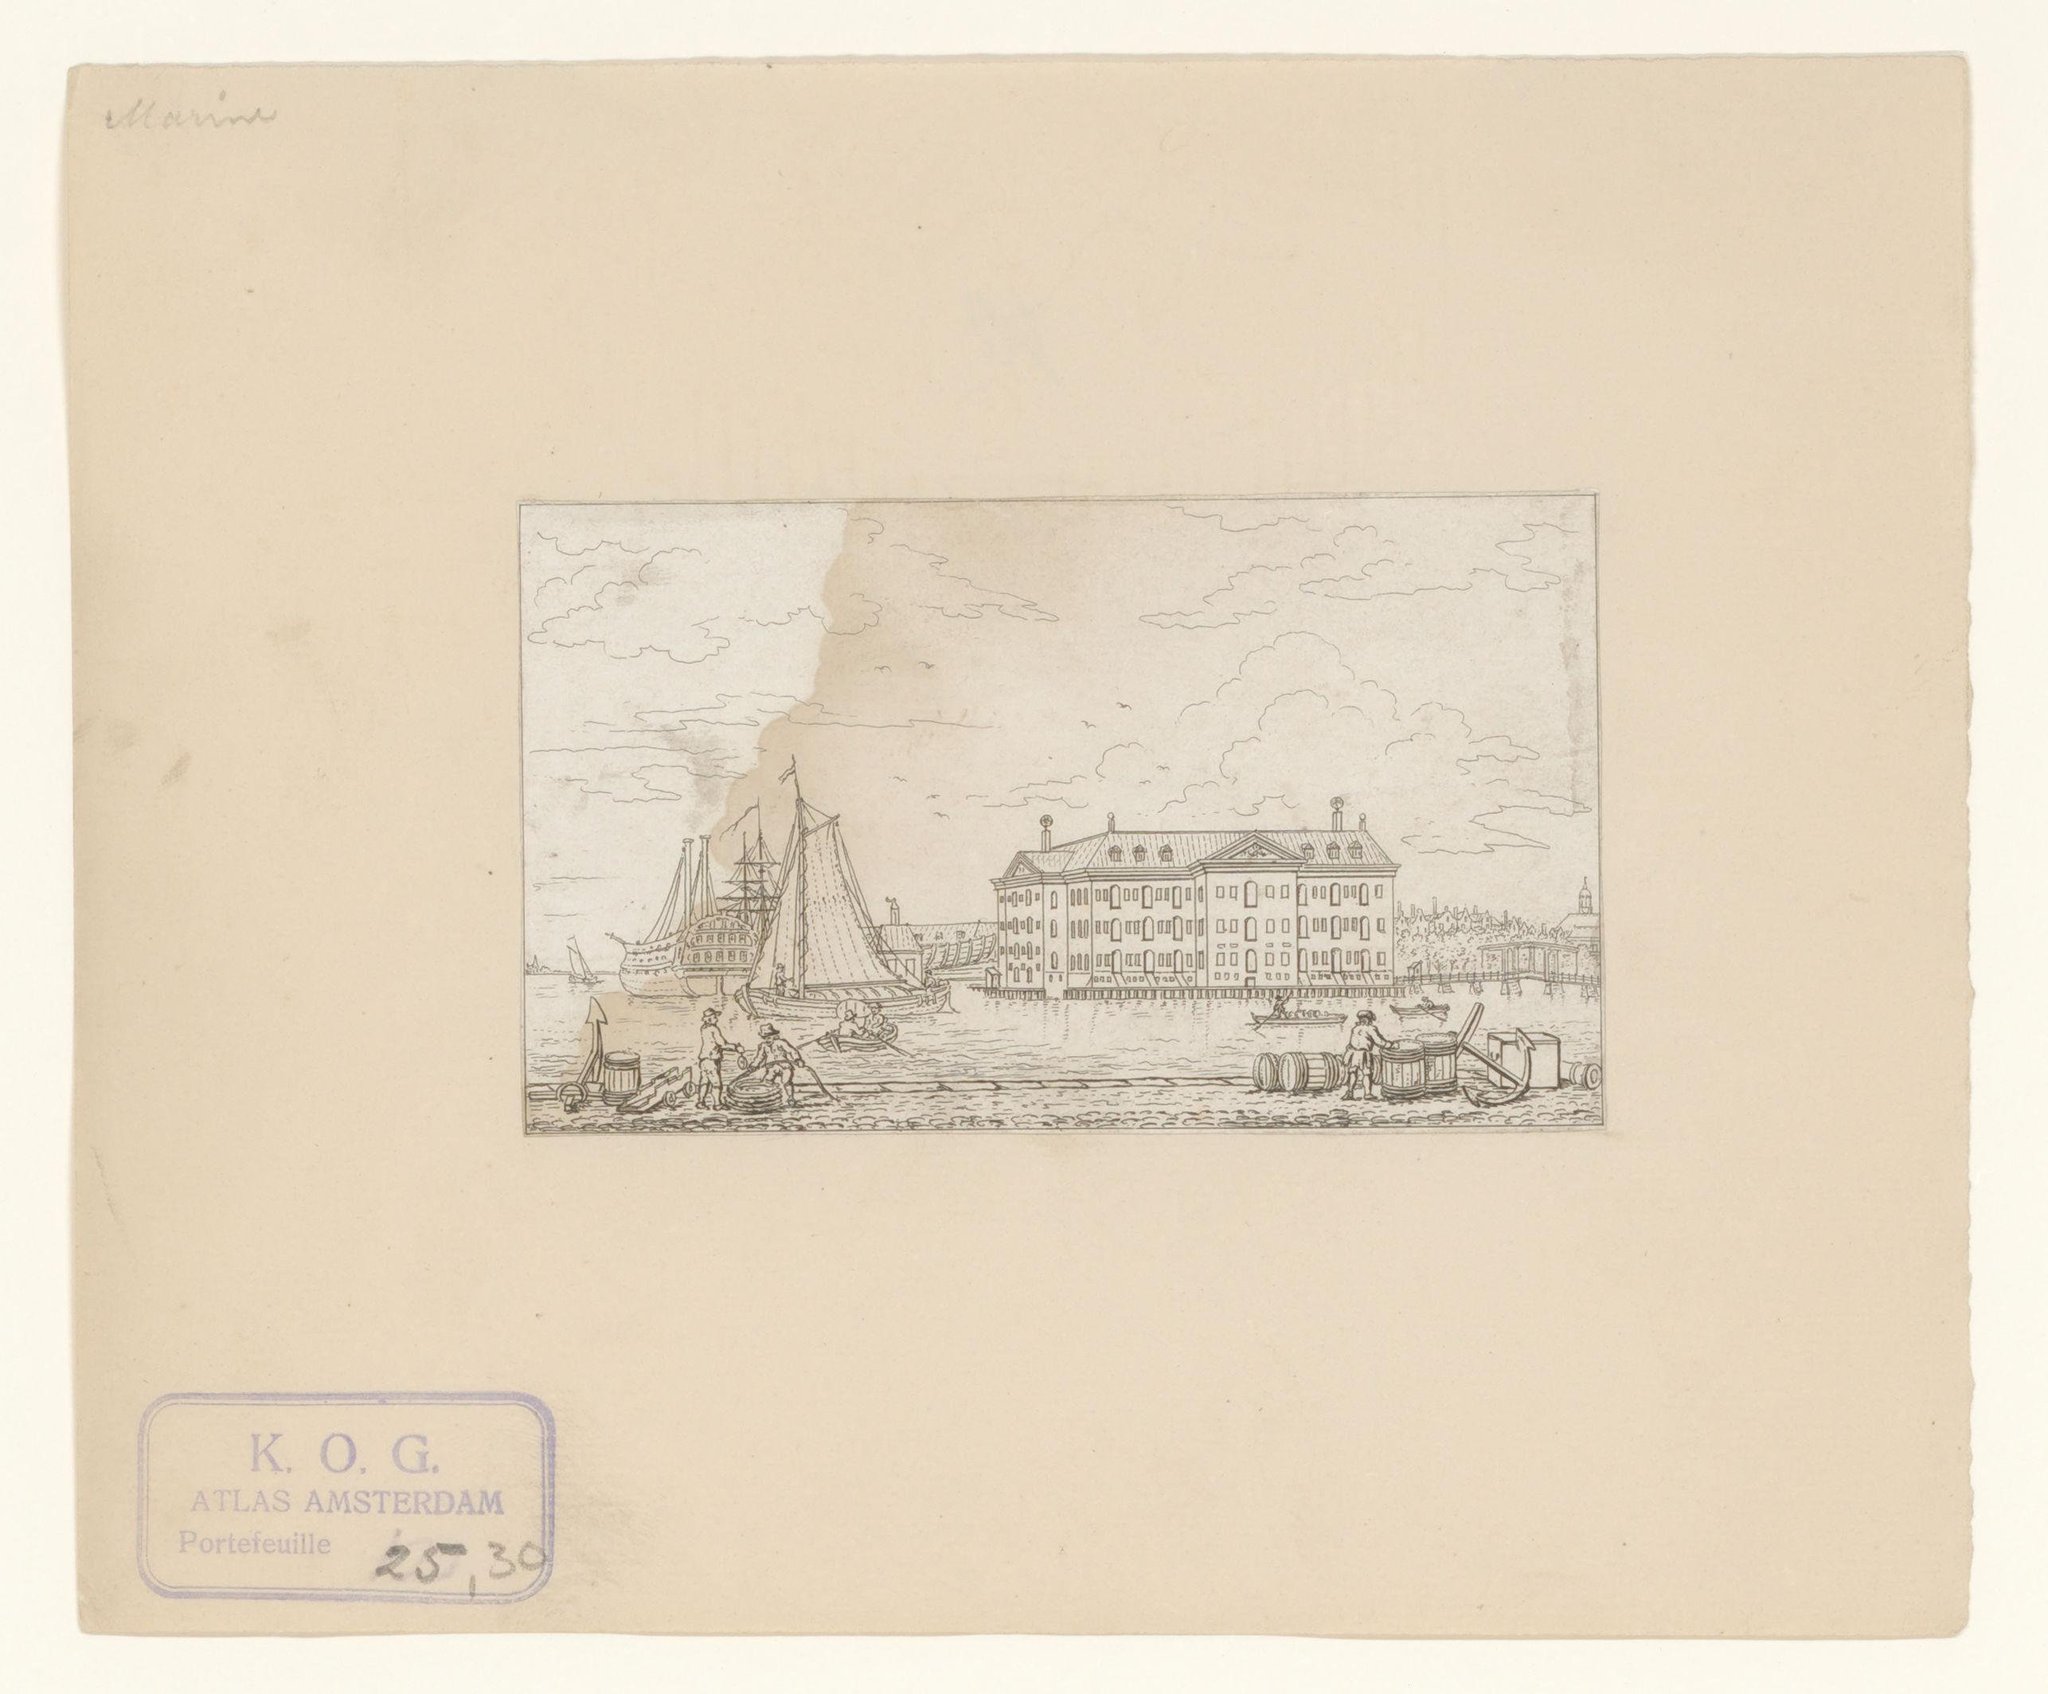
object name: print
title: Gezicht op 's Lands Zeemagazijn te Amsterdam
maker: Anonymous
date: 1750-1849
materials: paper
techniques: etching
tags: large-scale structure for storage, e.g.: warehouse, depot, silo, city-view in general; 'veduta', façade (of house or building)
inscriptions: collector's mark: ‘25.30’ Lugt 1641b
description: Onderwerpsrubriek binnen de Atlas Amsterdam: Krijgswezen I: De Admiraliteit van Amsterdam, A. Admiraliteitsgebouwen.